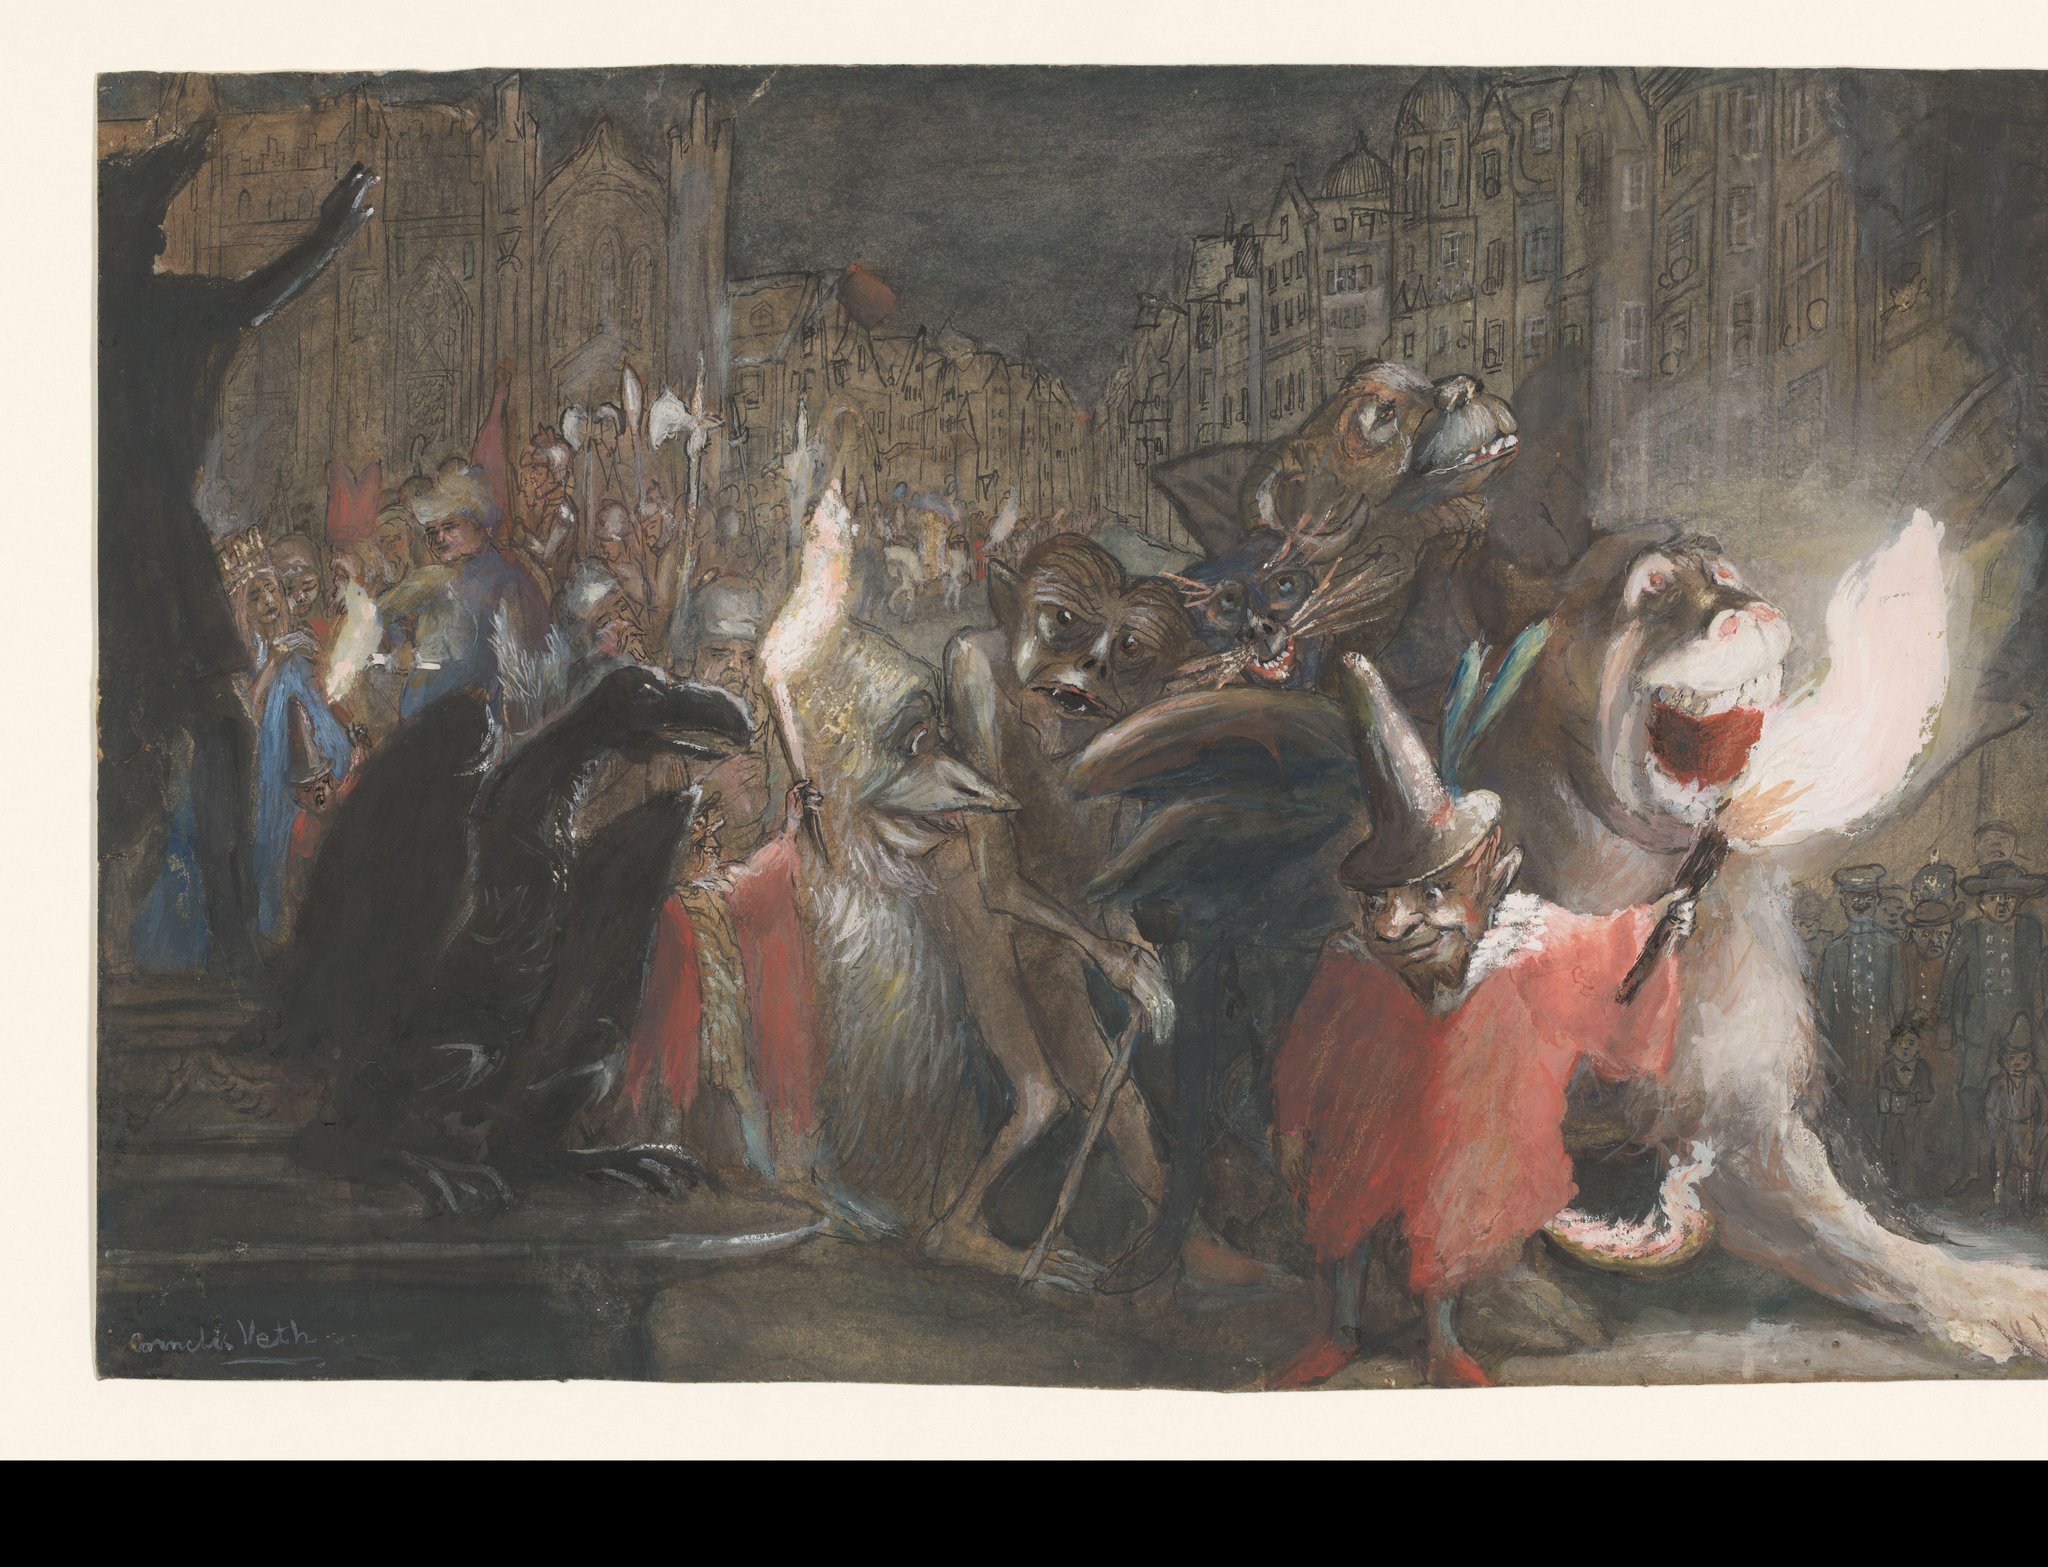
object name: print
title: Etudes de marines par F. Perrot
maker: ferdinand victor perrot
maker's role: print maker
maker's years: 1808-1841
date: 1835-1851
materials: paper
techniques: lithograph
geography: paris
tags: ships (in general)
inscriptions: collector's mark: Lugt 2228